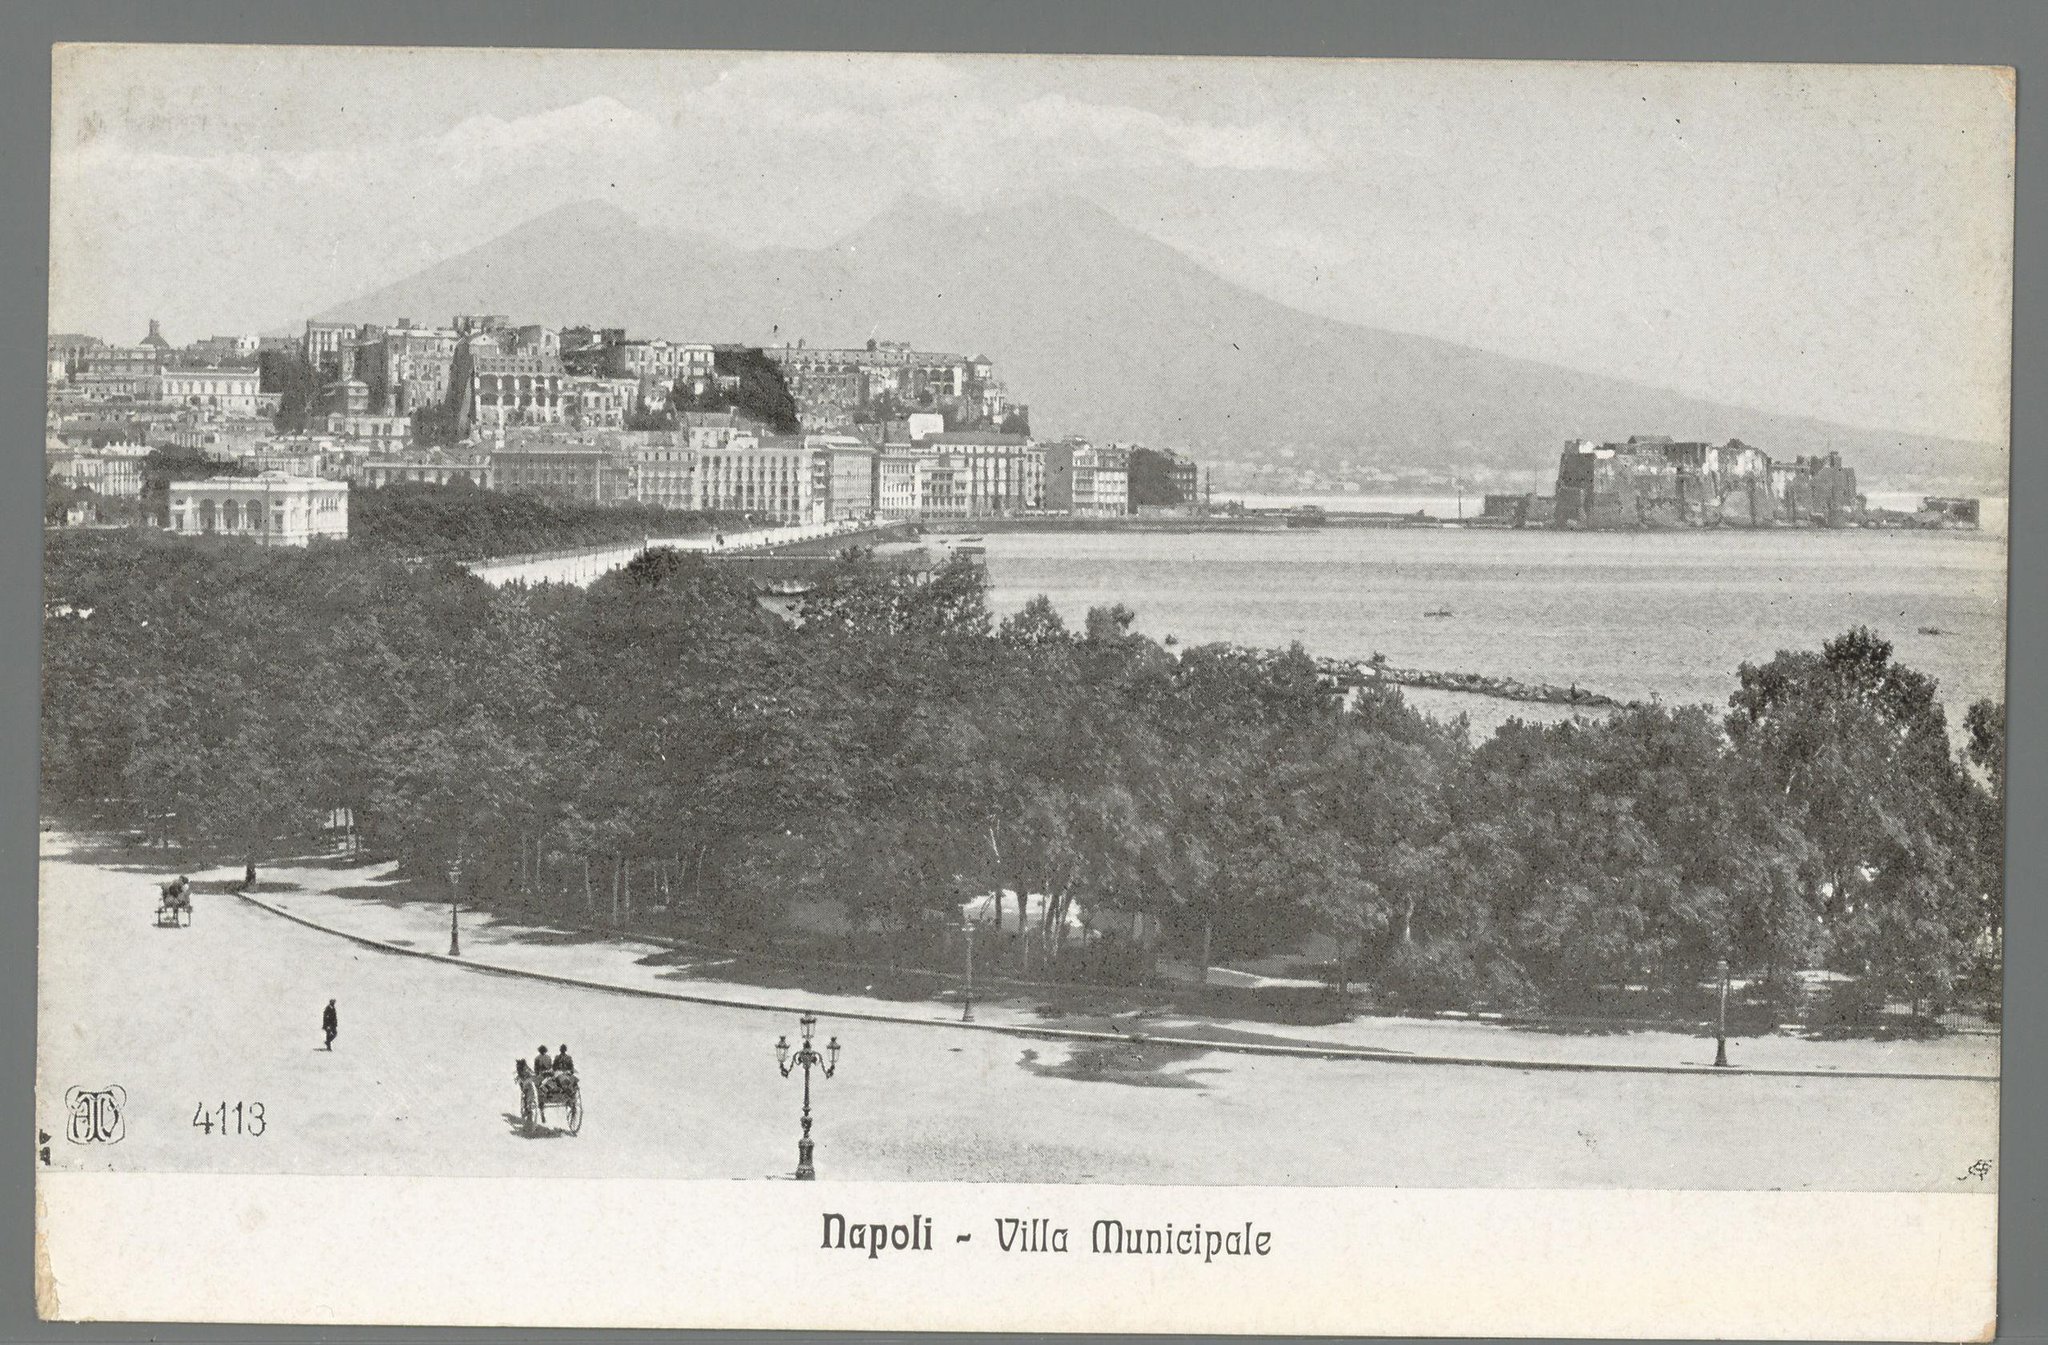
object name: ansichtkaart, prentbriefkaart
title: Napoli. Villa Municipale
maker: Anonymous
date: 1906-1910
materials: cardboard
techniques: autotype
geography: terni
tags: gulf, bay, castle, city-view, and landscape with man-made constructions (+ city(-scape) with figures, staffage)